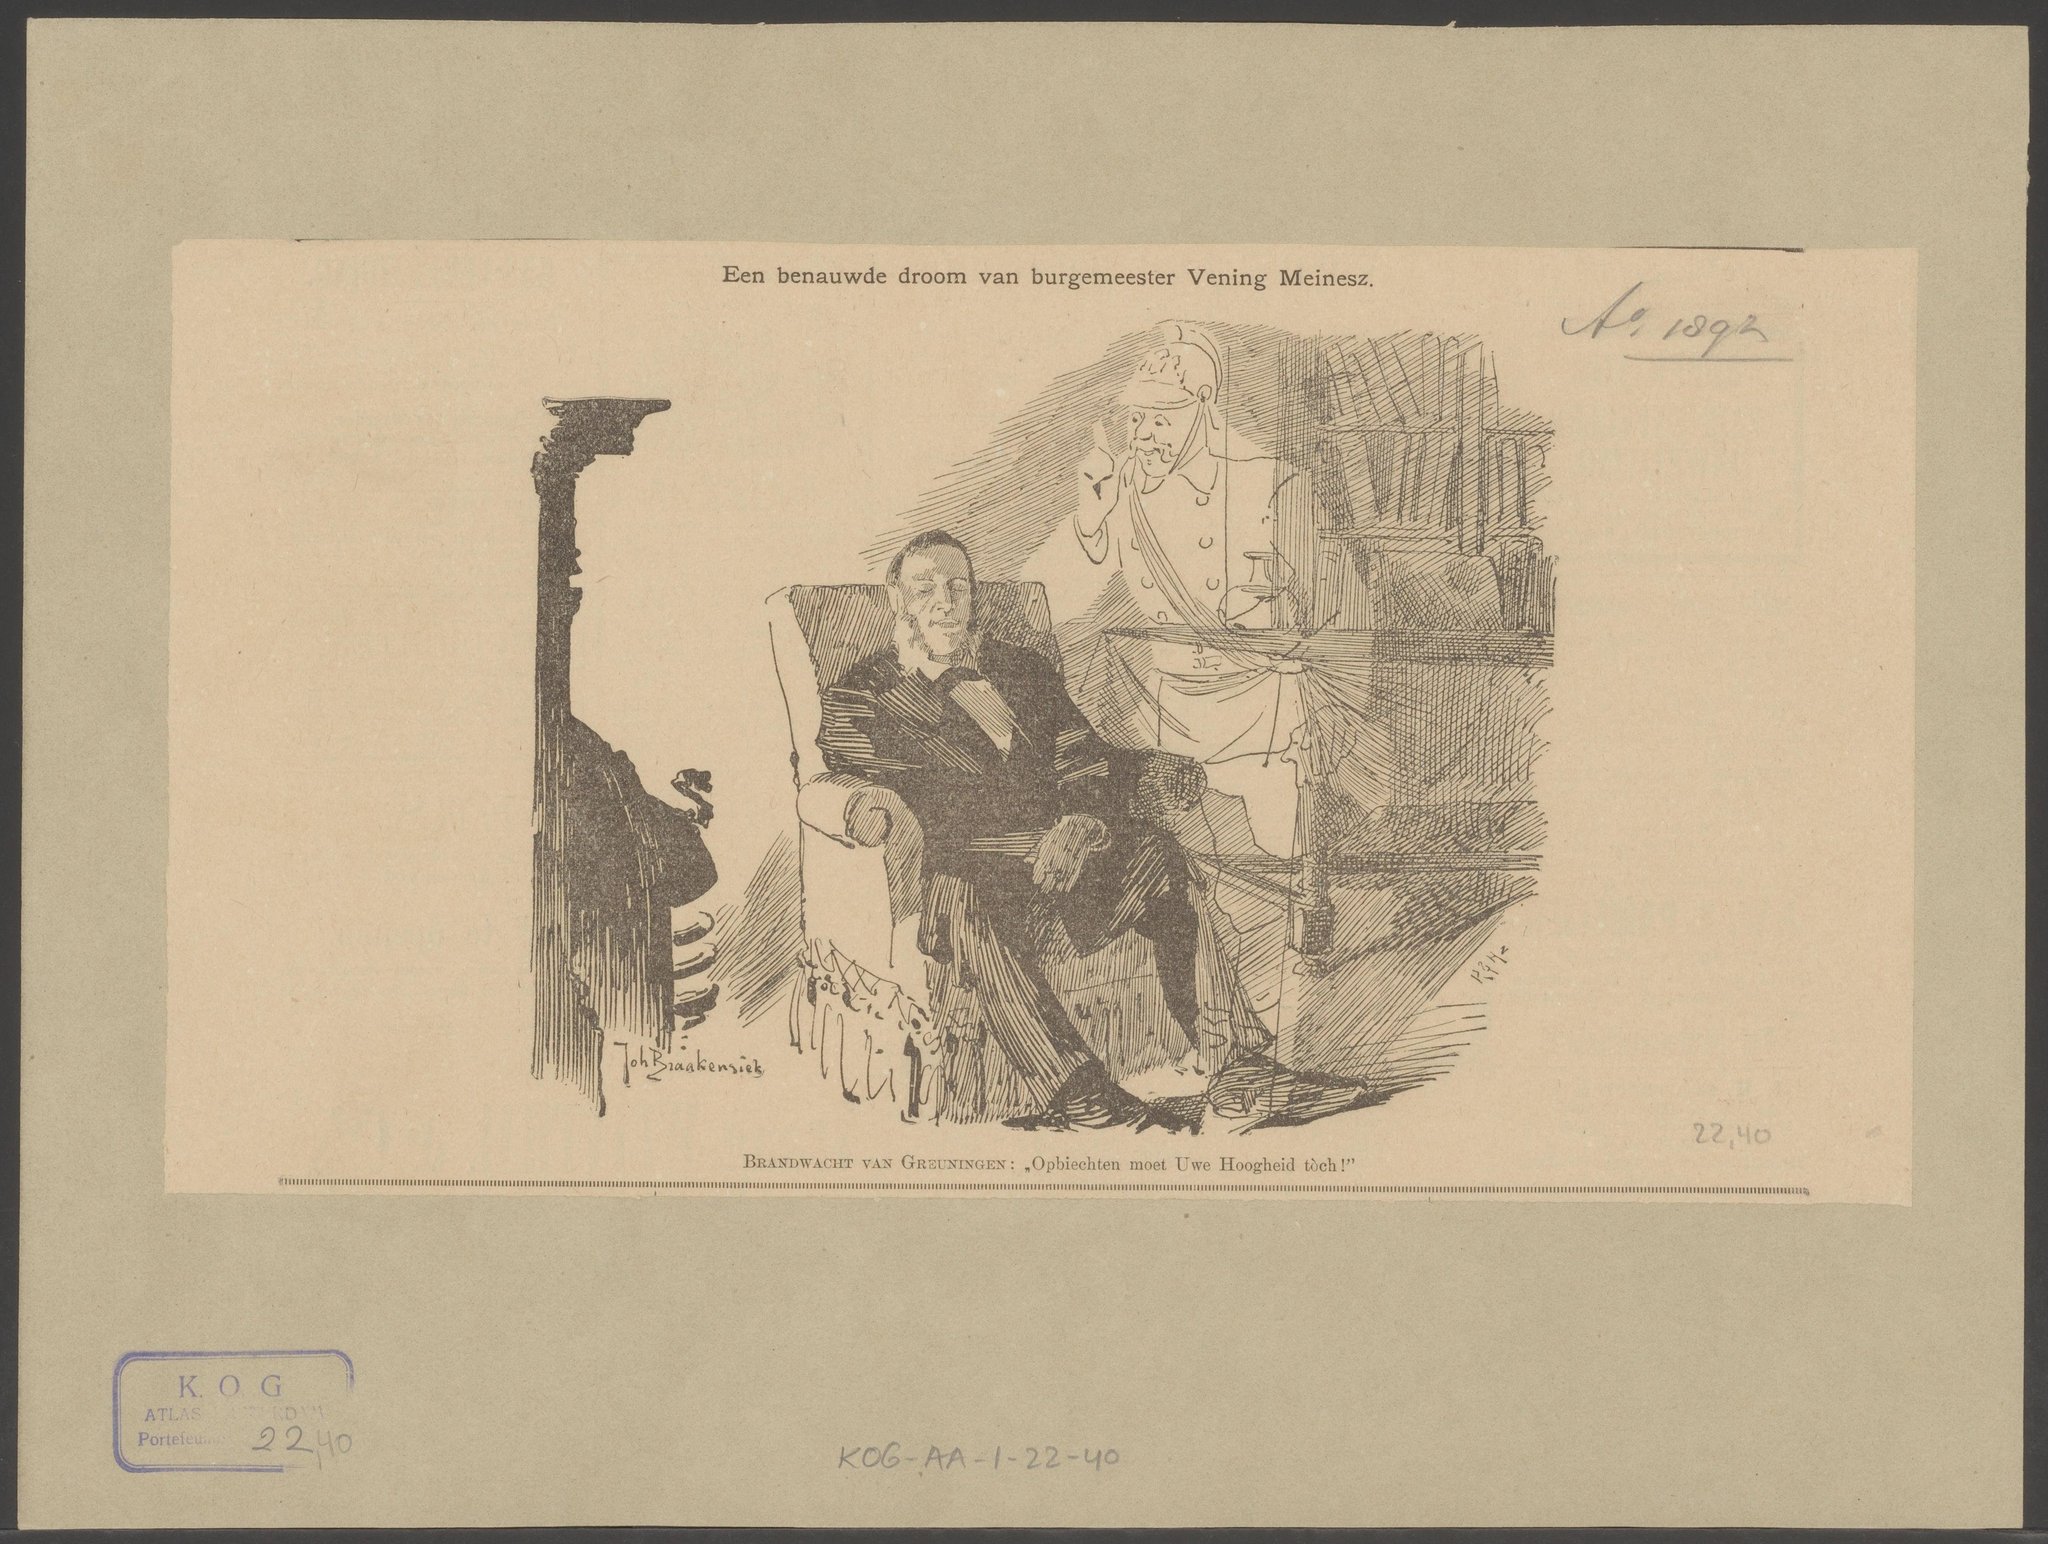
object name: photomechanical print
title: Een benauwde droom van burgemeester Vening Meinesz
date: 1892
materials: paper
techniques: letterpress printing, line block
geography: netherlands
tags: harlingen, dream, firemen, political caricatures and satires, amsterdam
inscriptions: collector's mark: Lugt 1641b, signature: ‘R&Hz.’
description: Onderwerpsrubriek binnen de Atlas Amsterdam: Bestrating, bruggen, wegen.